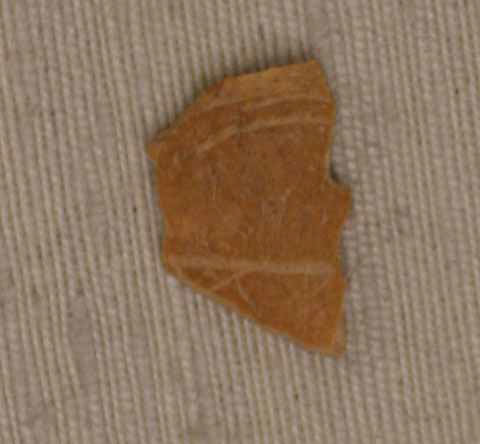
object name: fragment of a book cover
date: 401-800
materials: bone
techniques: engraving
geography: palestine